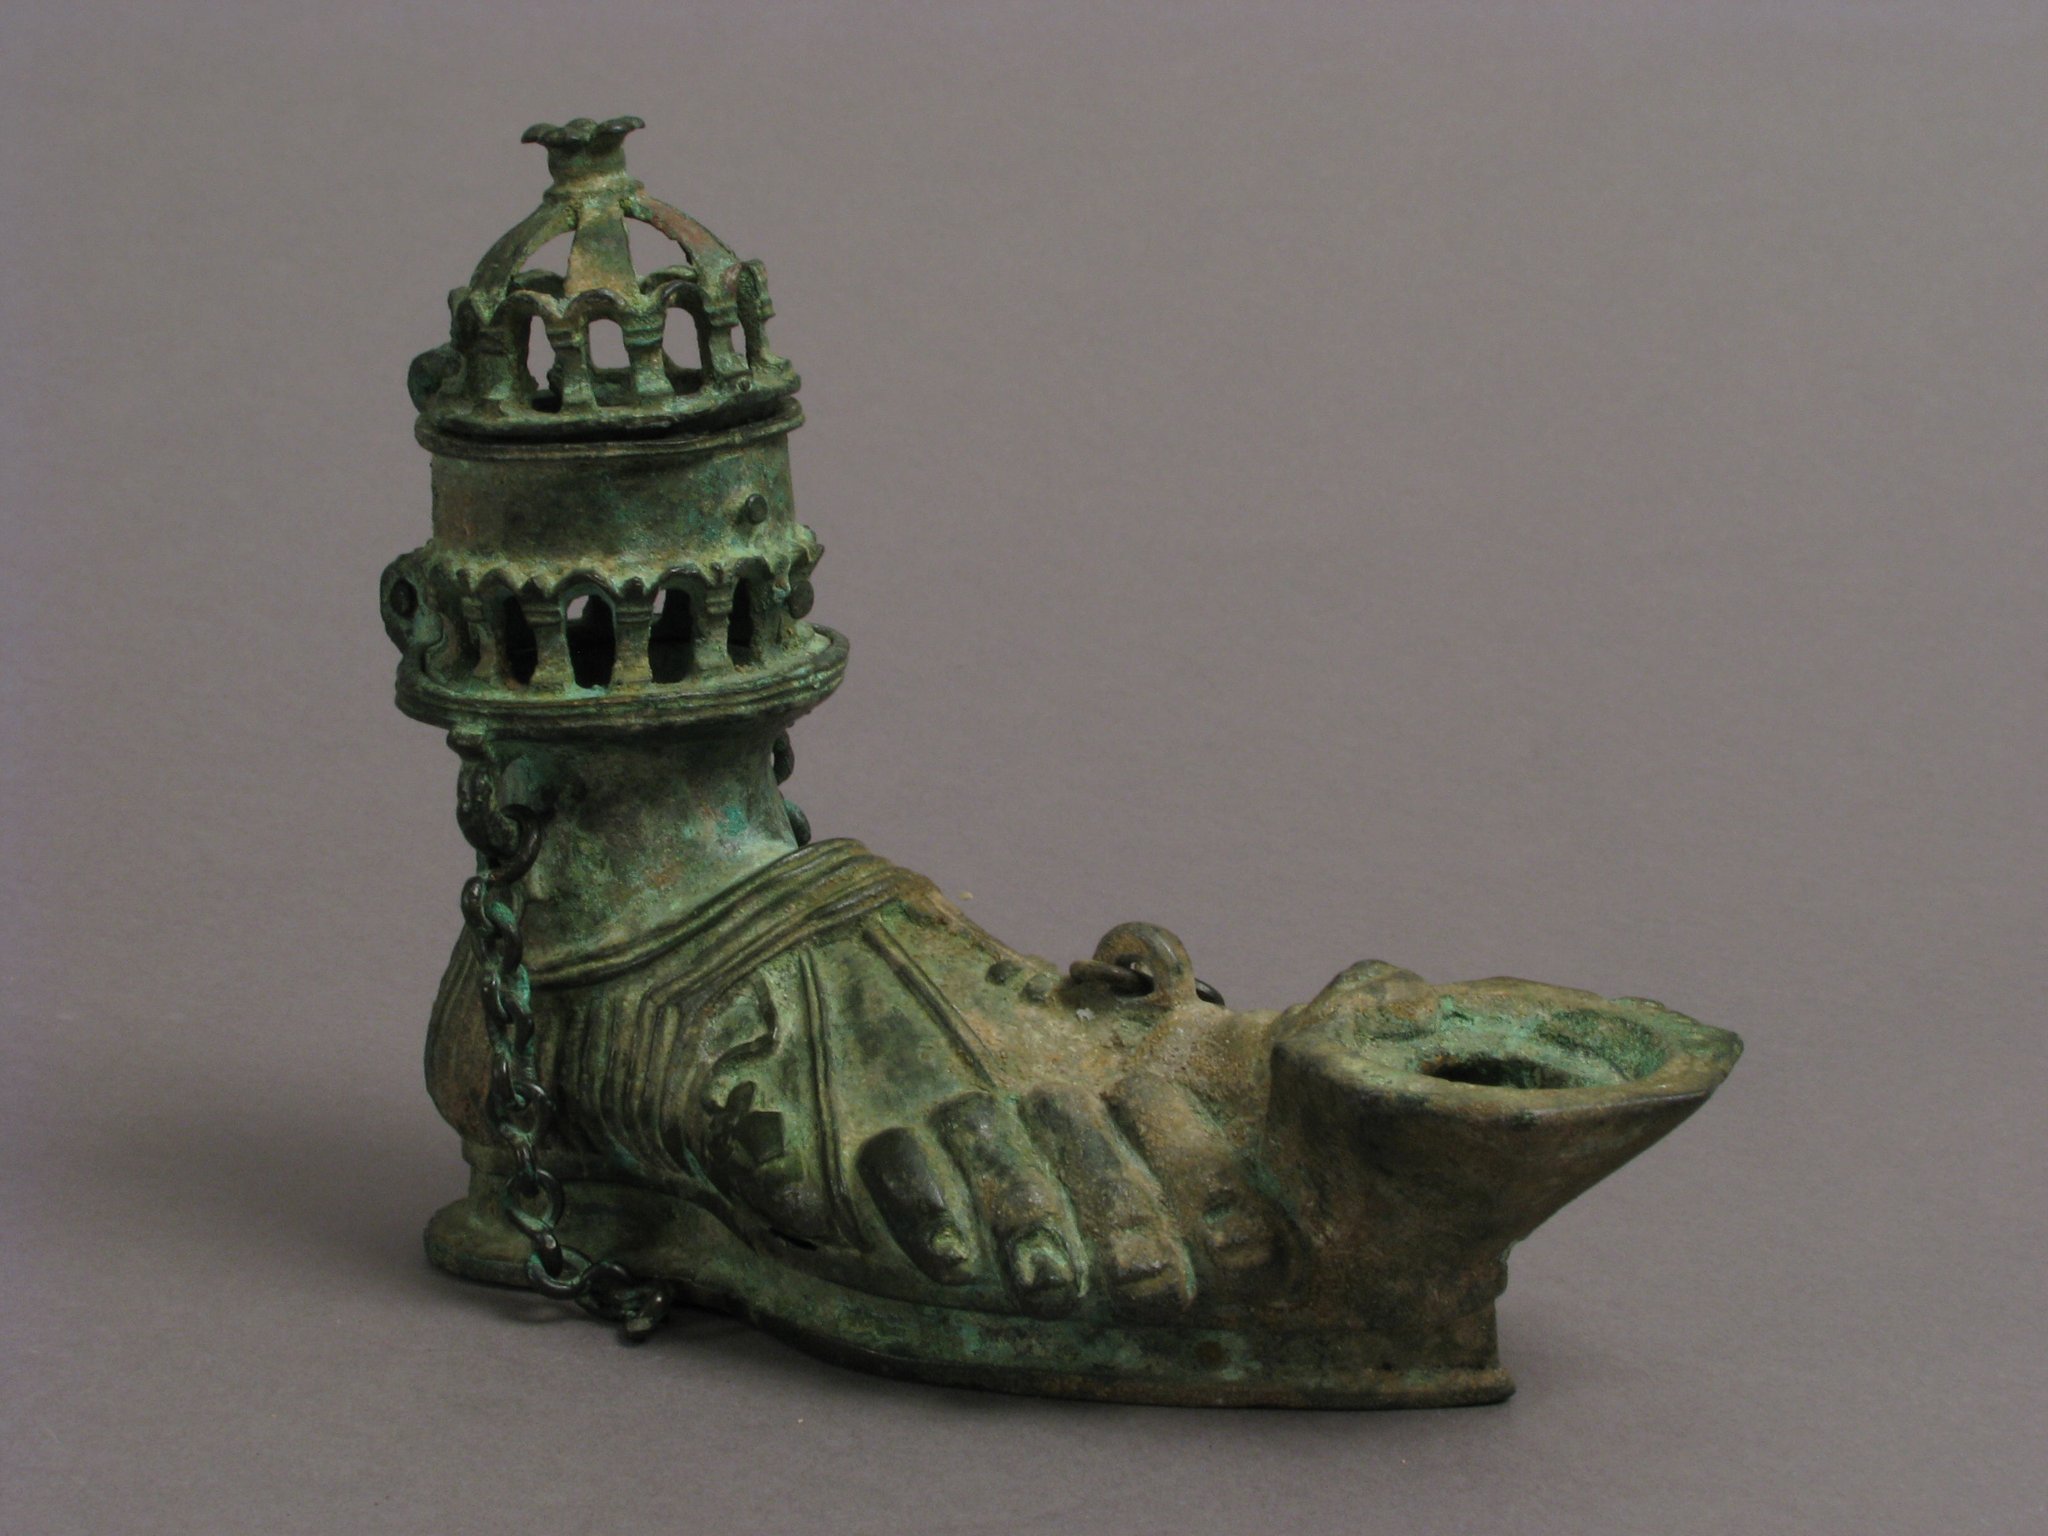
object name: lamp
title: Hanging Lamp in the Form of a Sandaled Right Foot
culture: byzantine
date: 401-500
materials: copper alloy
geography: syria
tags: feet